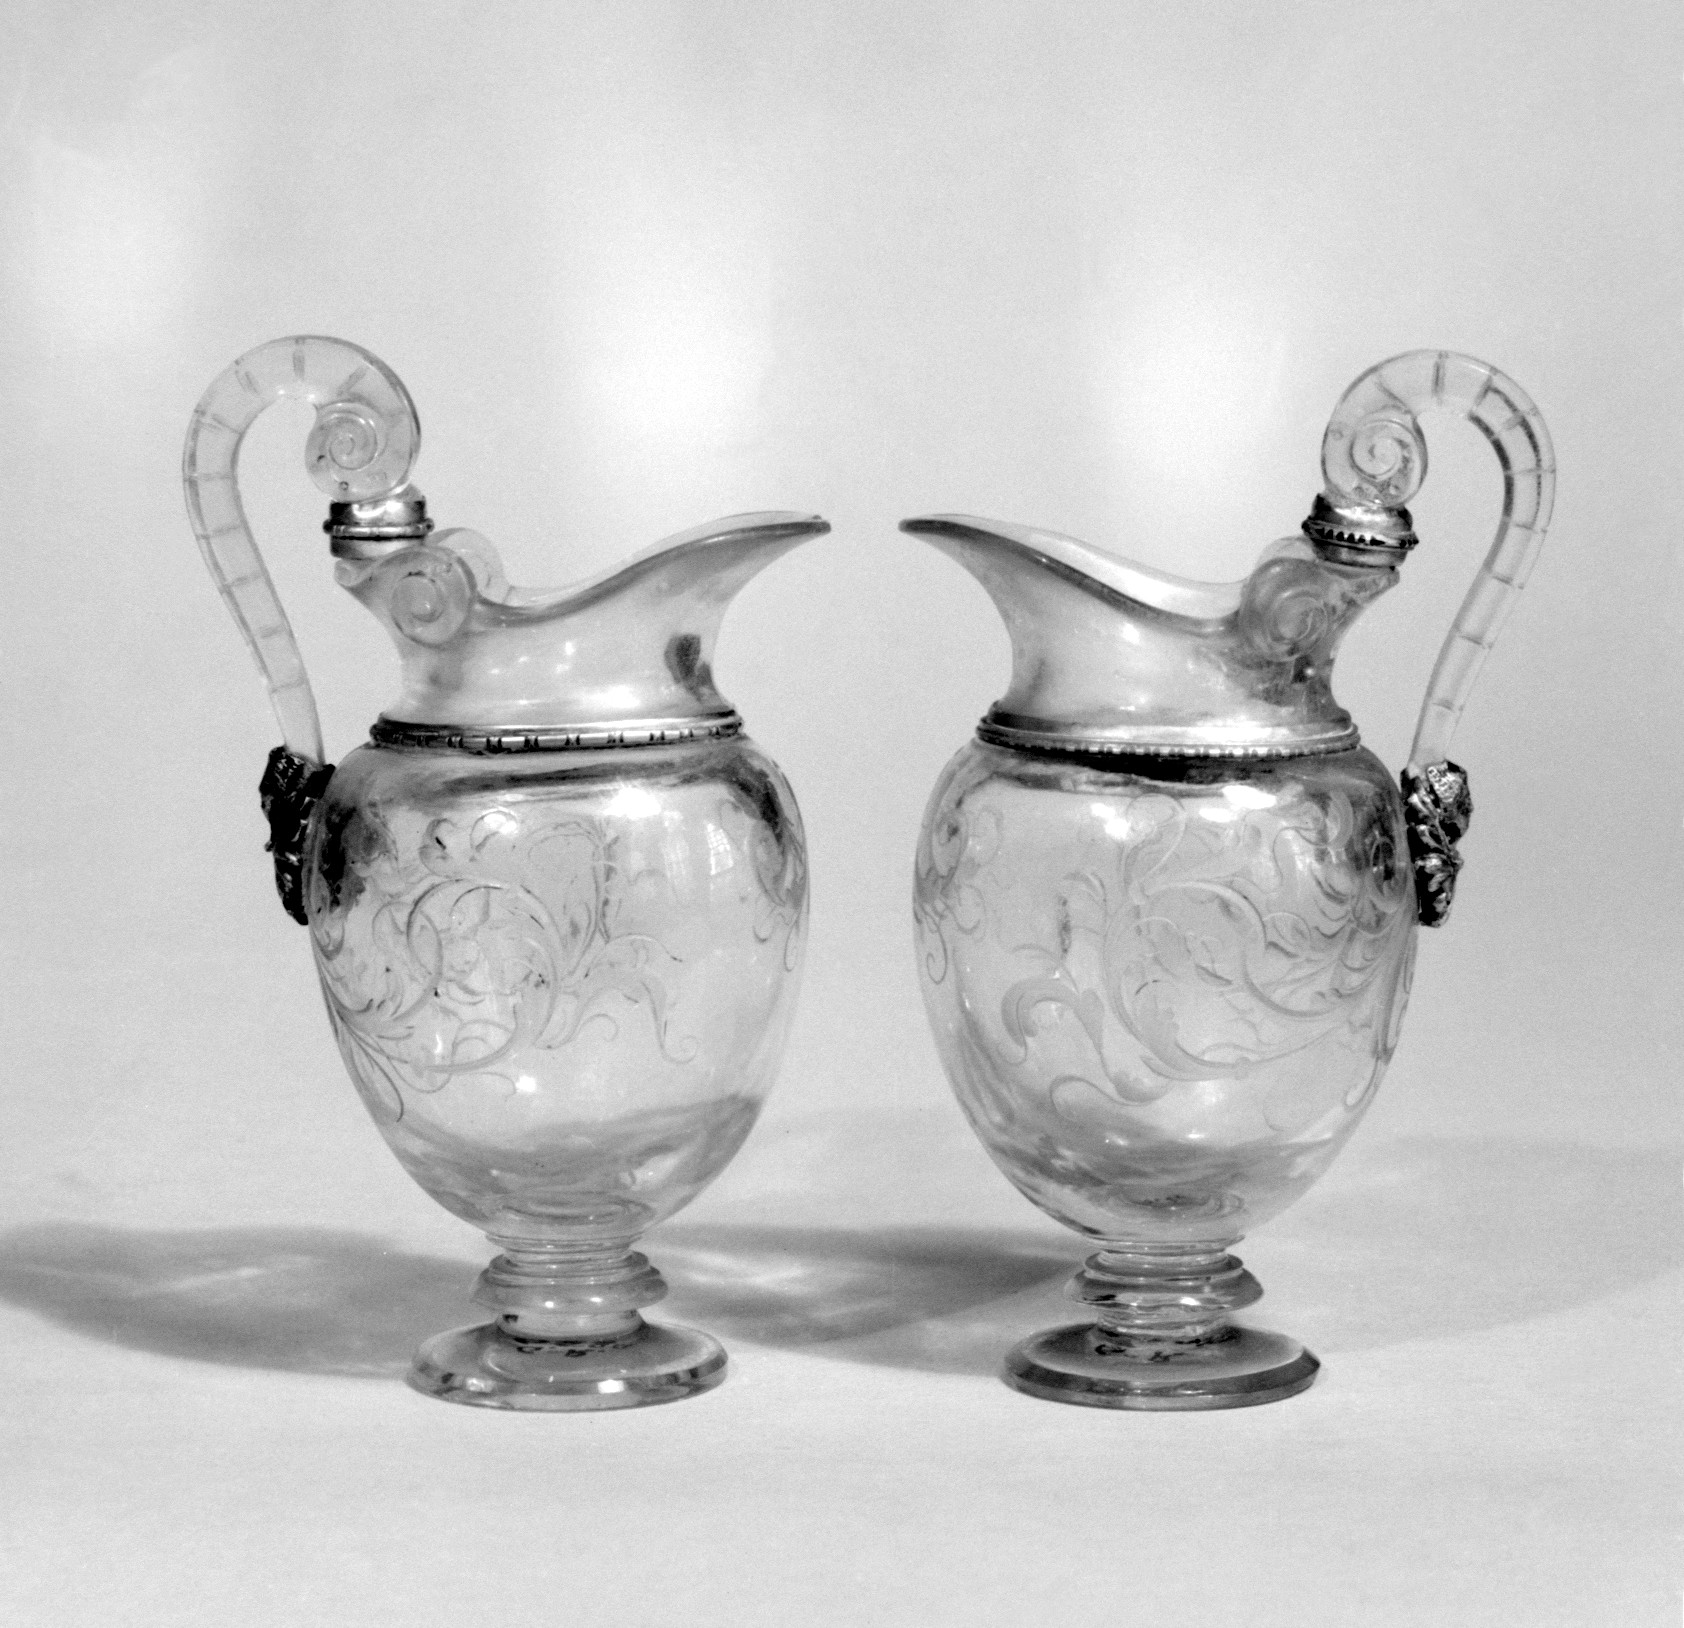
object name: altar cruet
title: Altar cruet (one of a pair)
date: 1601-1633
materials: gold, quartz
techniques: enamel